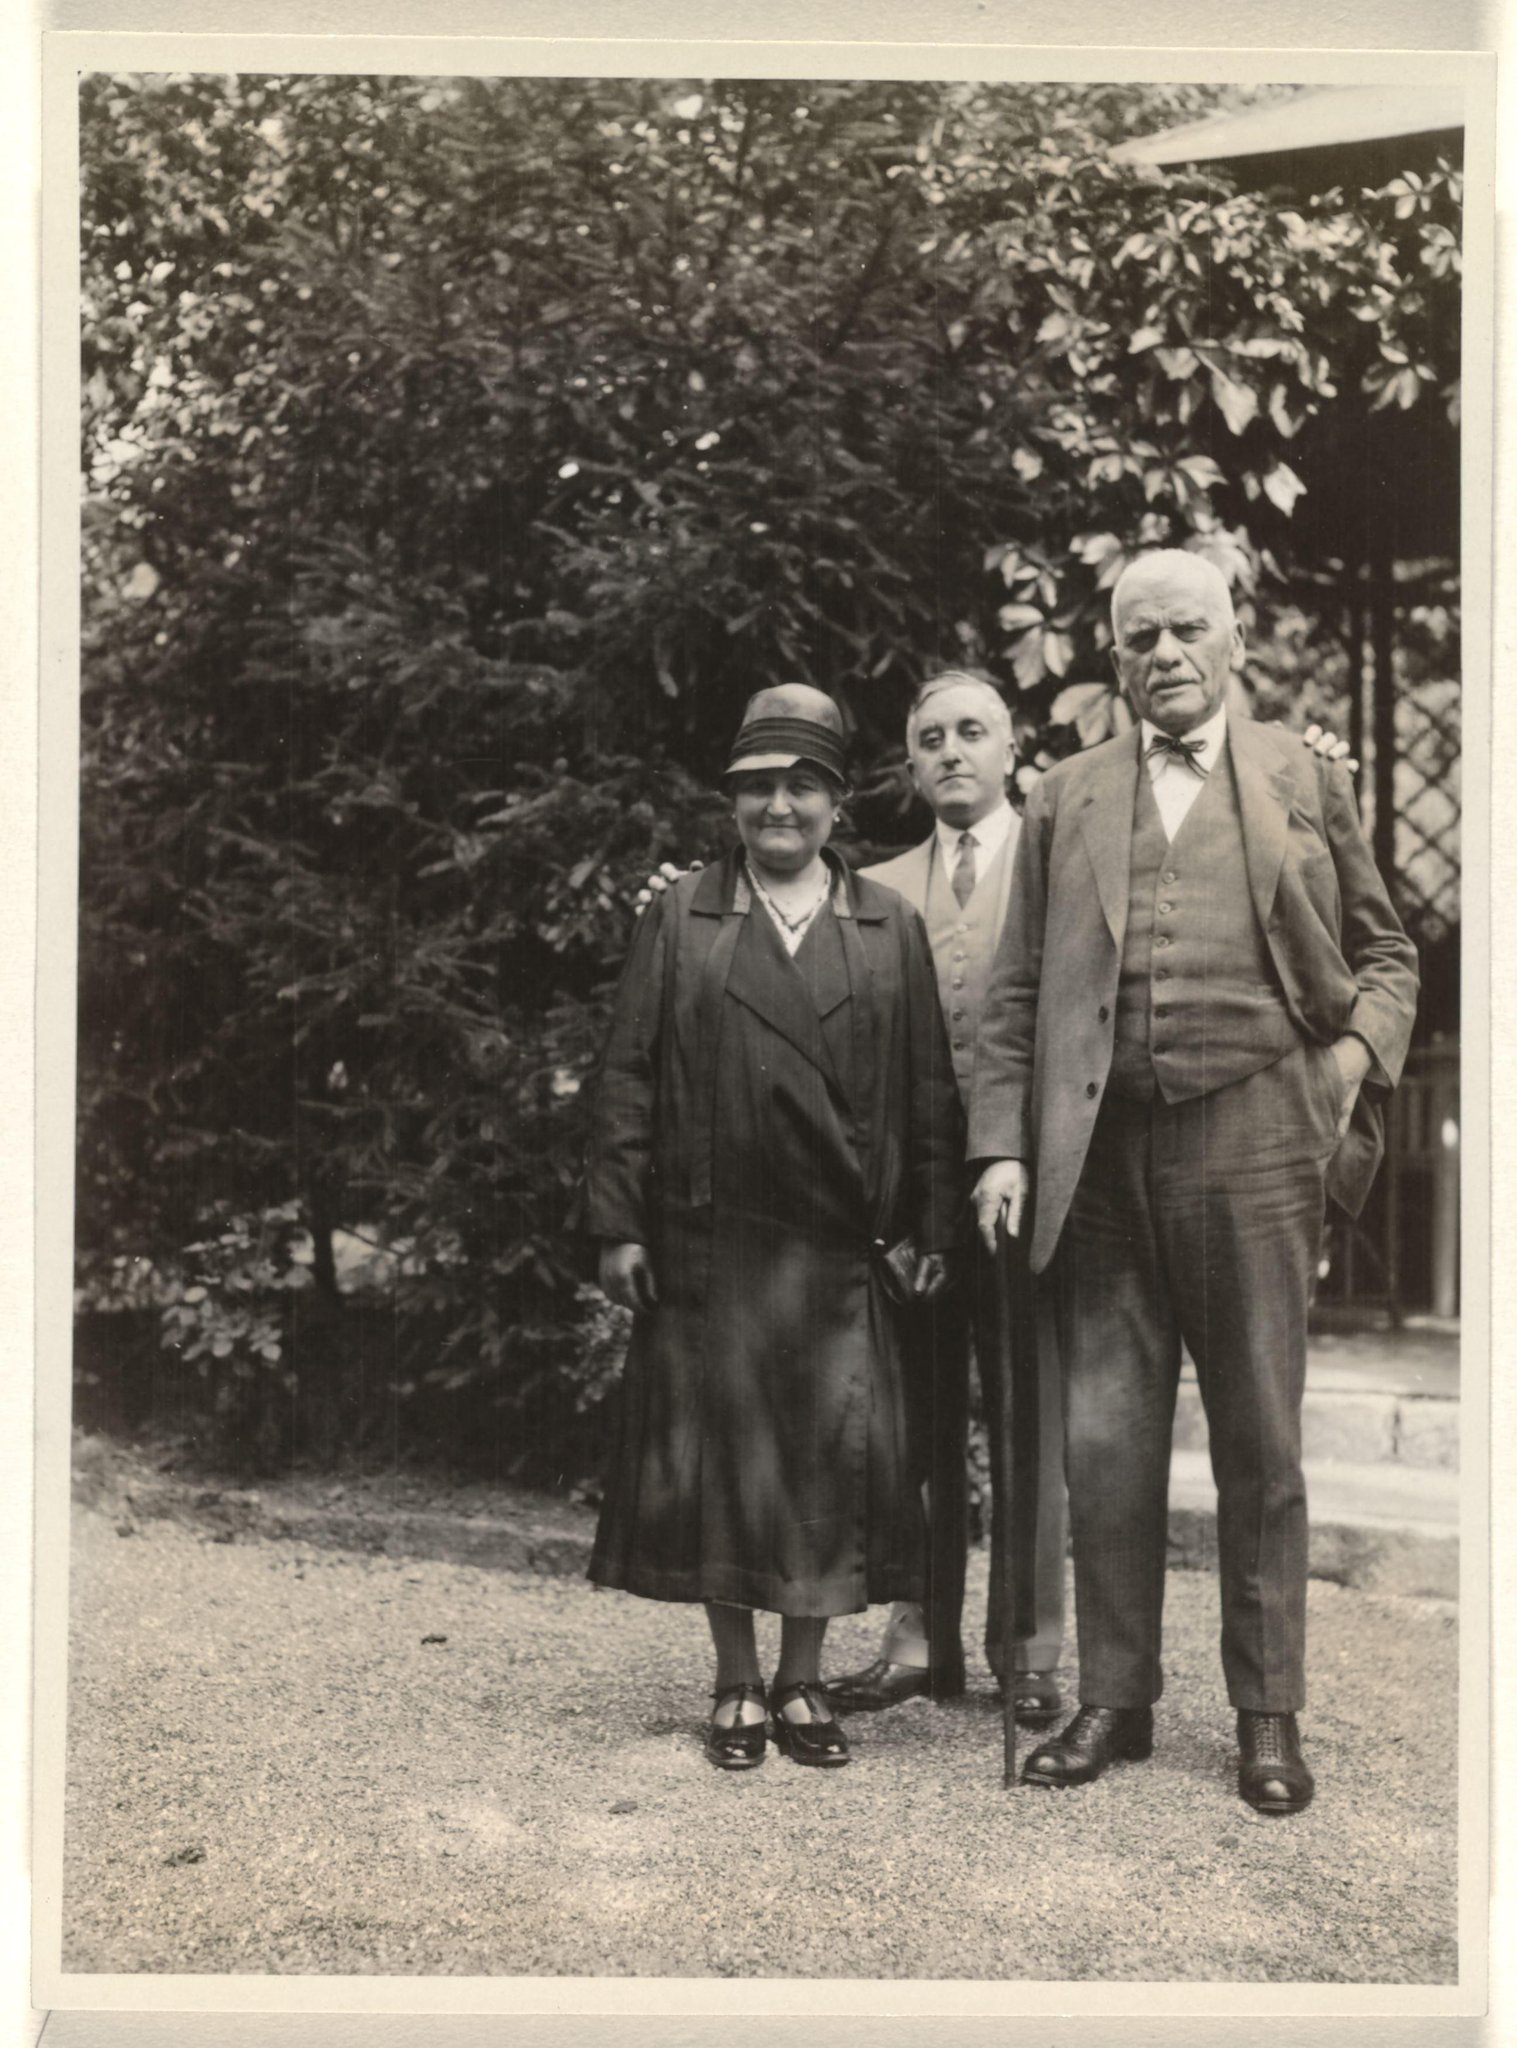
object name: photograph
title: Mathilde Wachenheimer-Wertheimer met haar echtgenoot Meir Wachenheimer en hun zoon Eugen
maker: Anonymous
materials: photographic support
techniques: gelatin silver print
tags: eugen wachenheimer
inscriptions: number: ‘950’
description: Mathilde Wachenheimer-Wertheimer (links) met haar echtgenoot Meir Wachenheimer (rechts) en hun zoon Eugen Wachenheimer (midden), staande in een tuin, met een deel van een bouwwerk op de achtergrond.